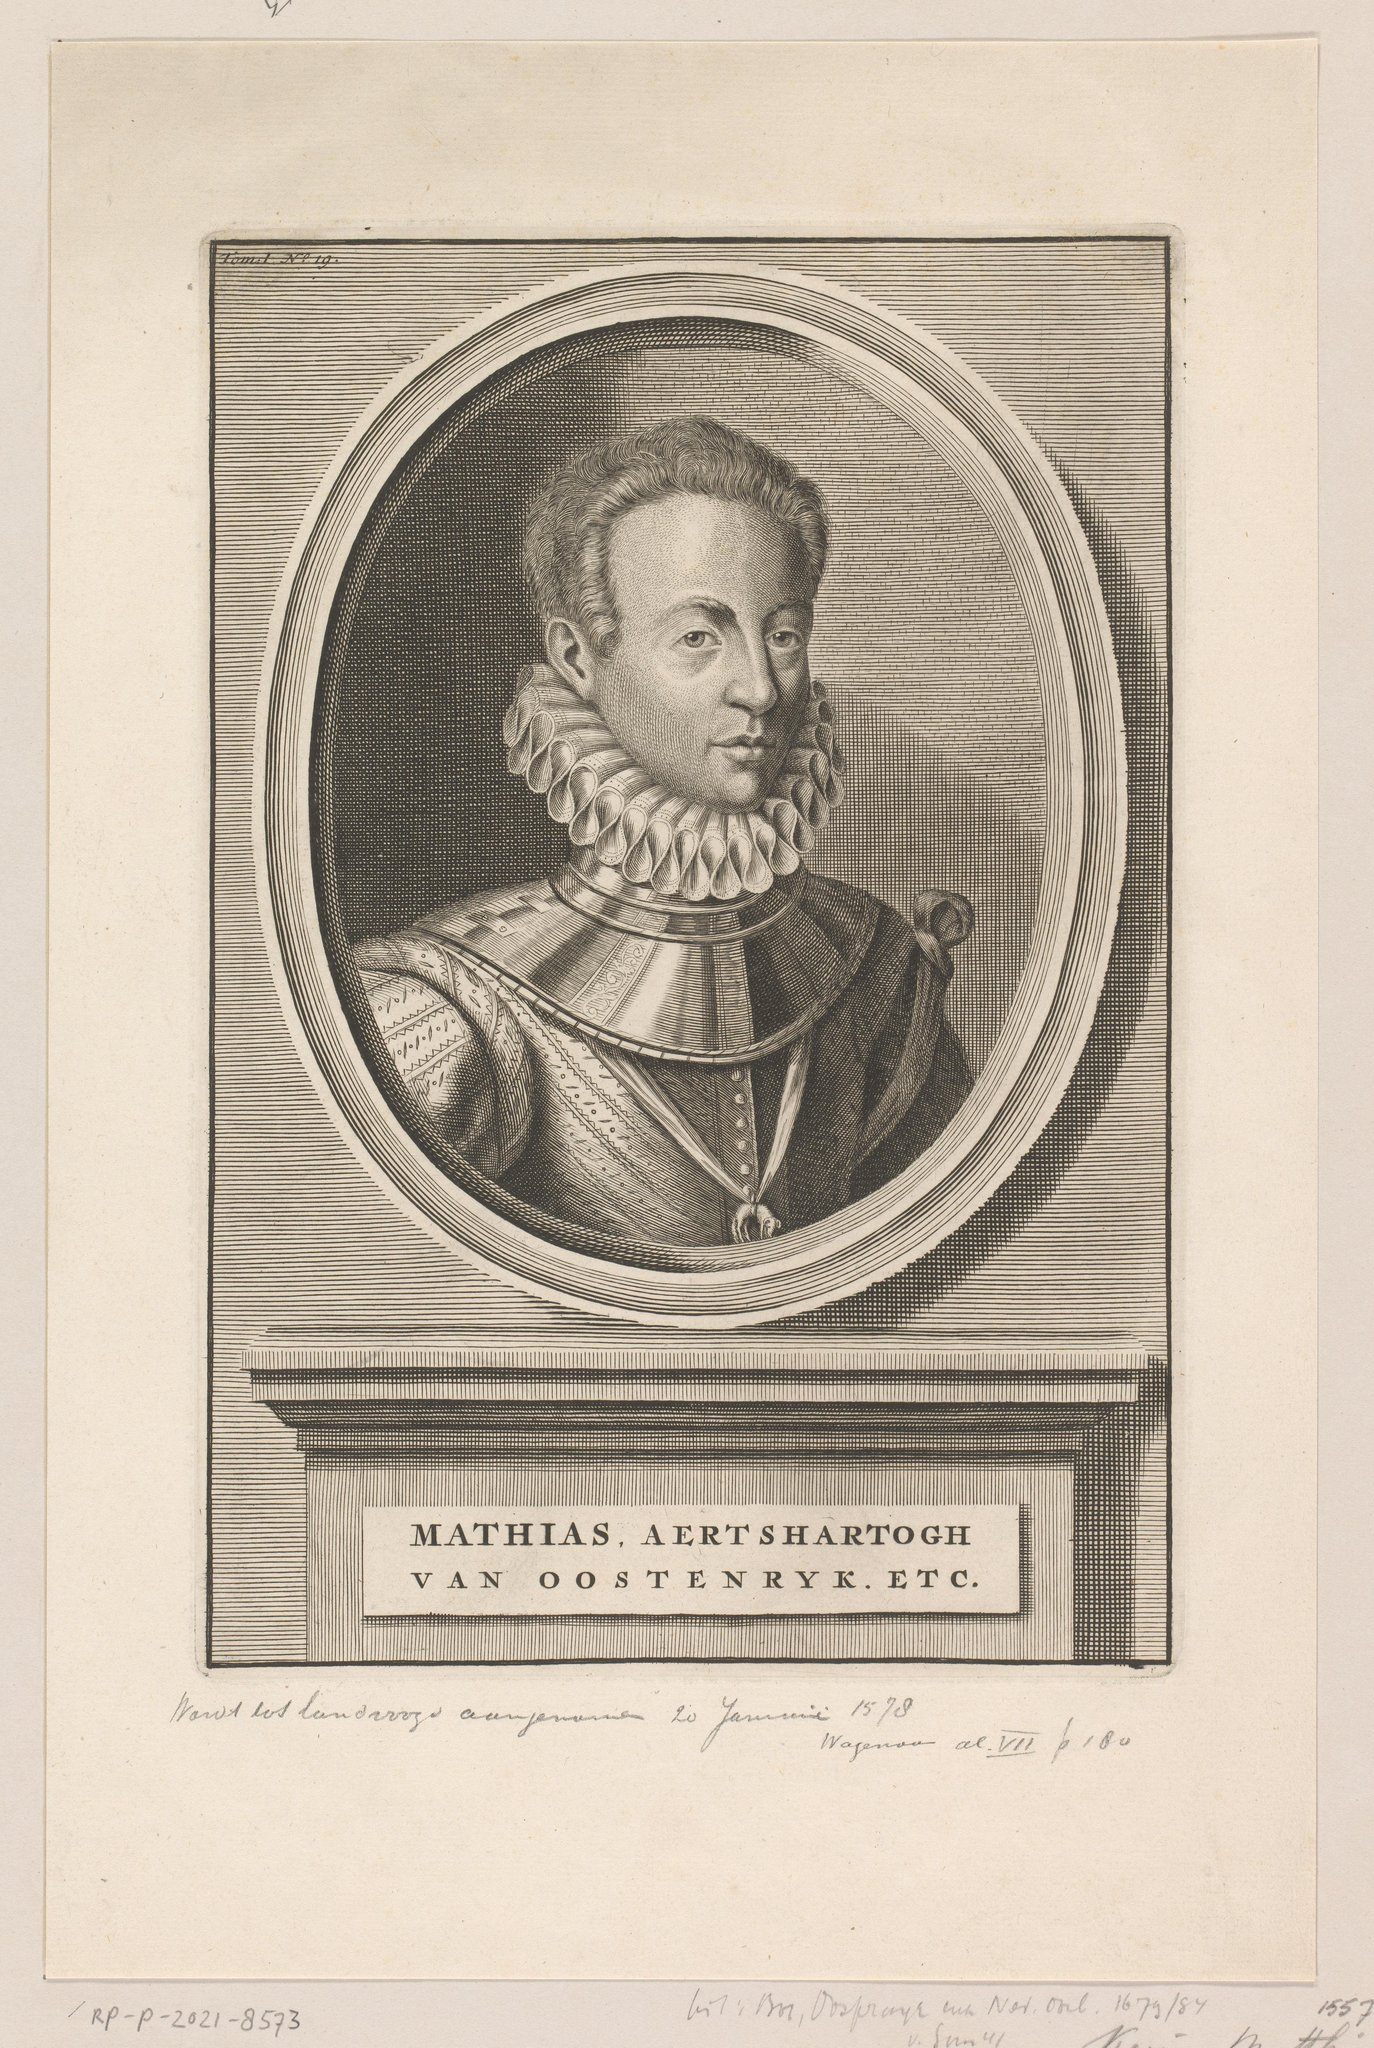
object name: book illustration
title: Portret van keizer Matthias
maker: Anonymous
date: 1730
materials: paper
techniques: engraving, etching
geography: northern netherlands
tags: vienna, matthias van oostenrijk (rooms-duits keizer), ornament ~ medallion, historical persons, knighthood order of the golden fleece, emperor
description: Prent waarschijnlijk uit: Le Clerc, Jean. Geschiedenissen der Vereenigde Nederlanden. Amsterdam: Zacharias Chatelain, 1730, dl. 1. De prent is in een eerdere staat gebruikt in Bors 'Oorsprongk, begin, en vervolgh der Nederlandsche oorlogen (...)', 1679.